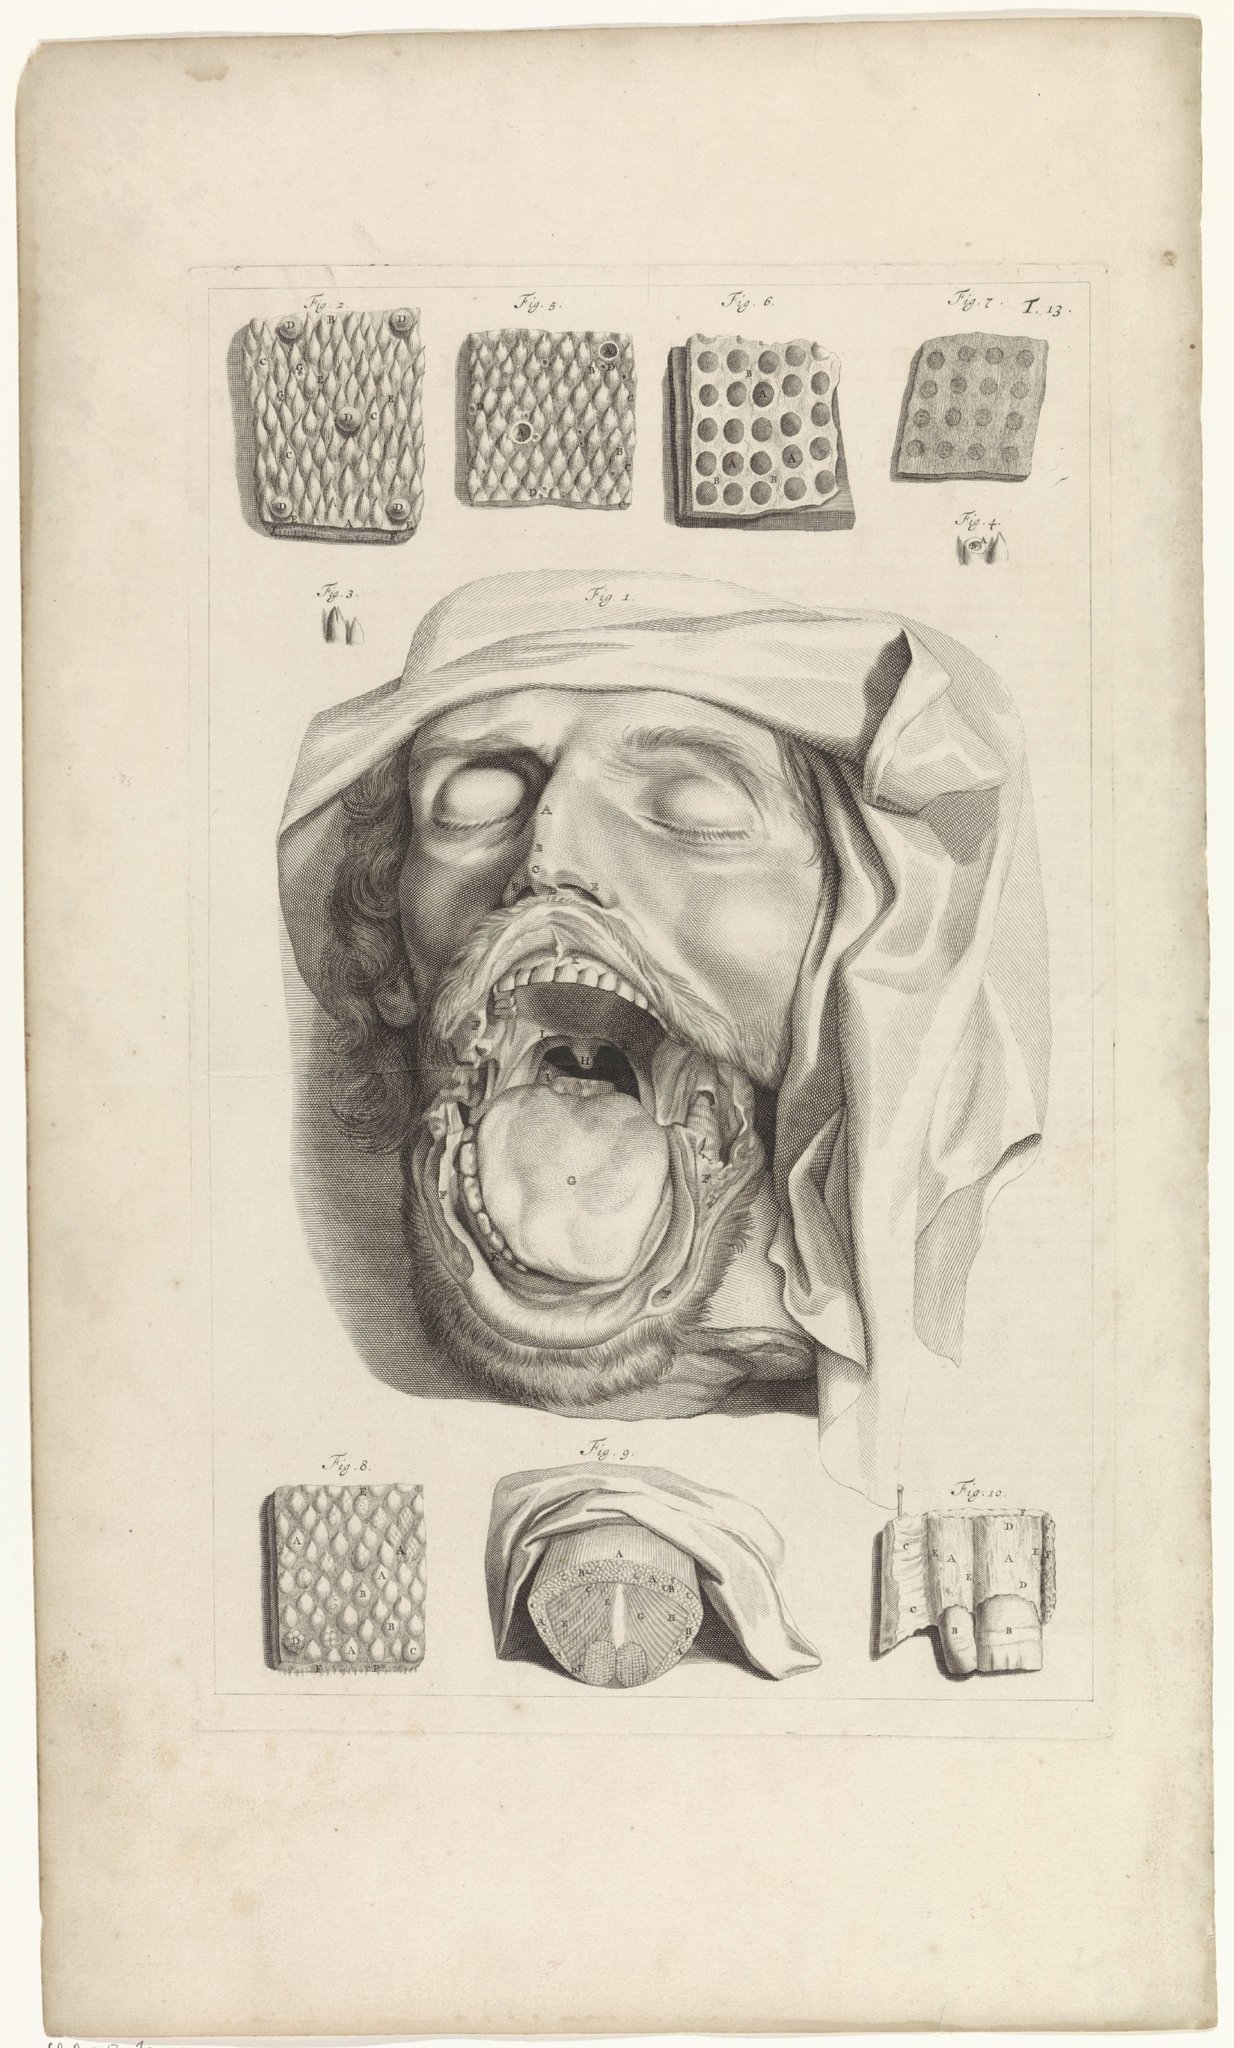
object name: book illustration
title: Anatomische studie van het hoofd, de neus en de tong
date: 1685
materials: paper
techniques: engraving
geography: amsterdam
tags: head (internal) (+ front view), nasal cavity, mouth and throat cavity, mouth wide open (+ front view), skin (human)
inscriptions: collector's mark: Lugt 2228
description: Boekillustratie voor Bidloo, Godefridus. Anatomia humani corporis centum & quinque tabulis, per art. G. de Lairesse ad vivum delineatis, de monstrata, veterum recentiorumque inventis explicata plurimisque, hactenus non detectis, illustrata. Amsterdam: Weduwe Joannes van Someren, Hendrick Boom en erven Dirk Boom, 1685.